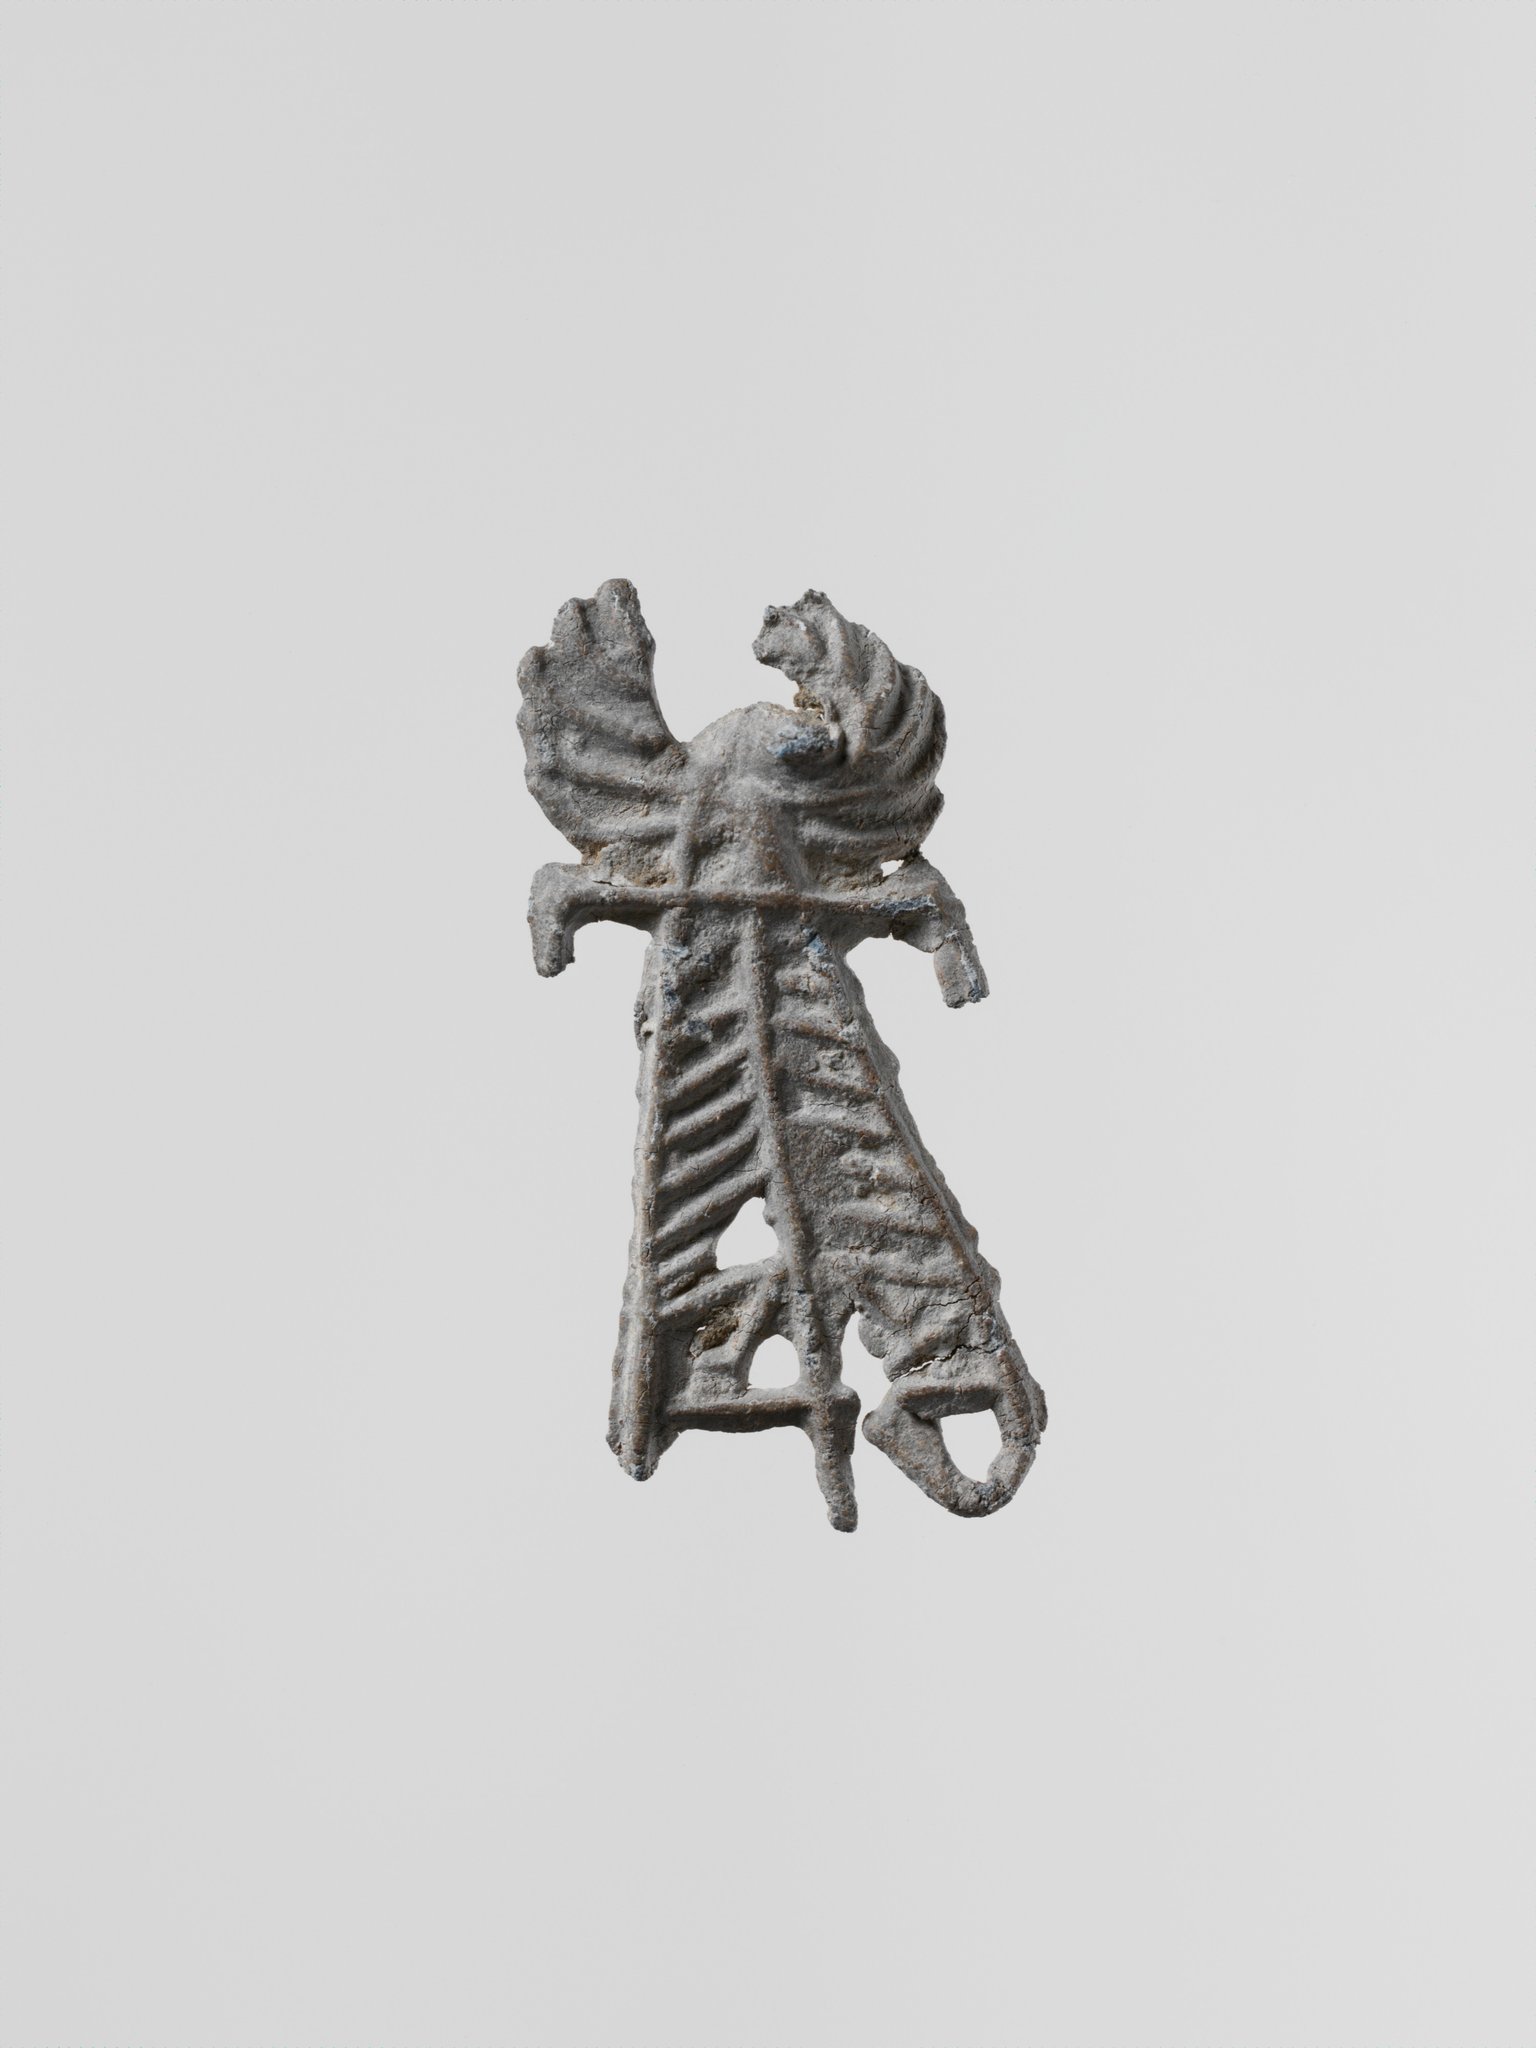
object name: statuette of artemis orthia winged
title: Lead figure of a winged goddess, possibly Artemis Orthia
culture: greek, laconian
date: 634-501 BCE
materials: lead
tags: artemis